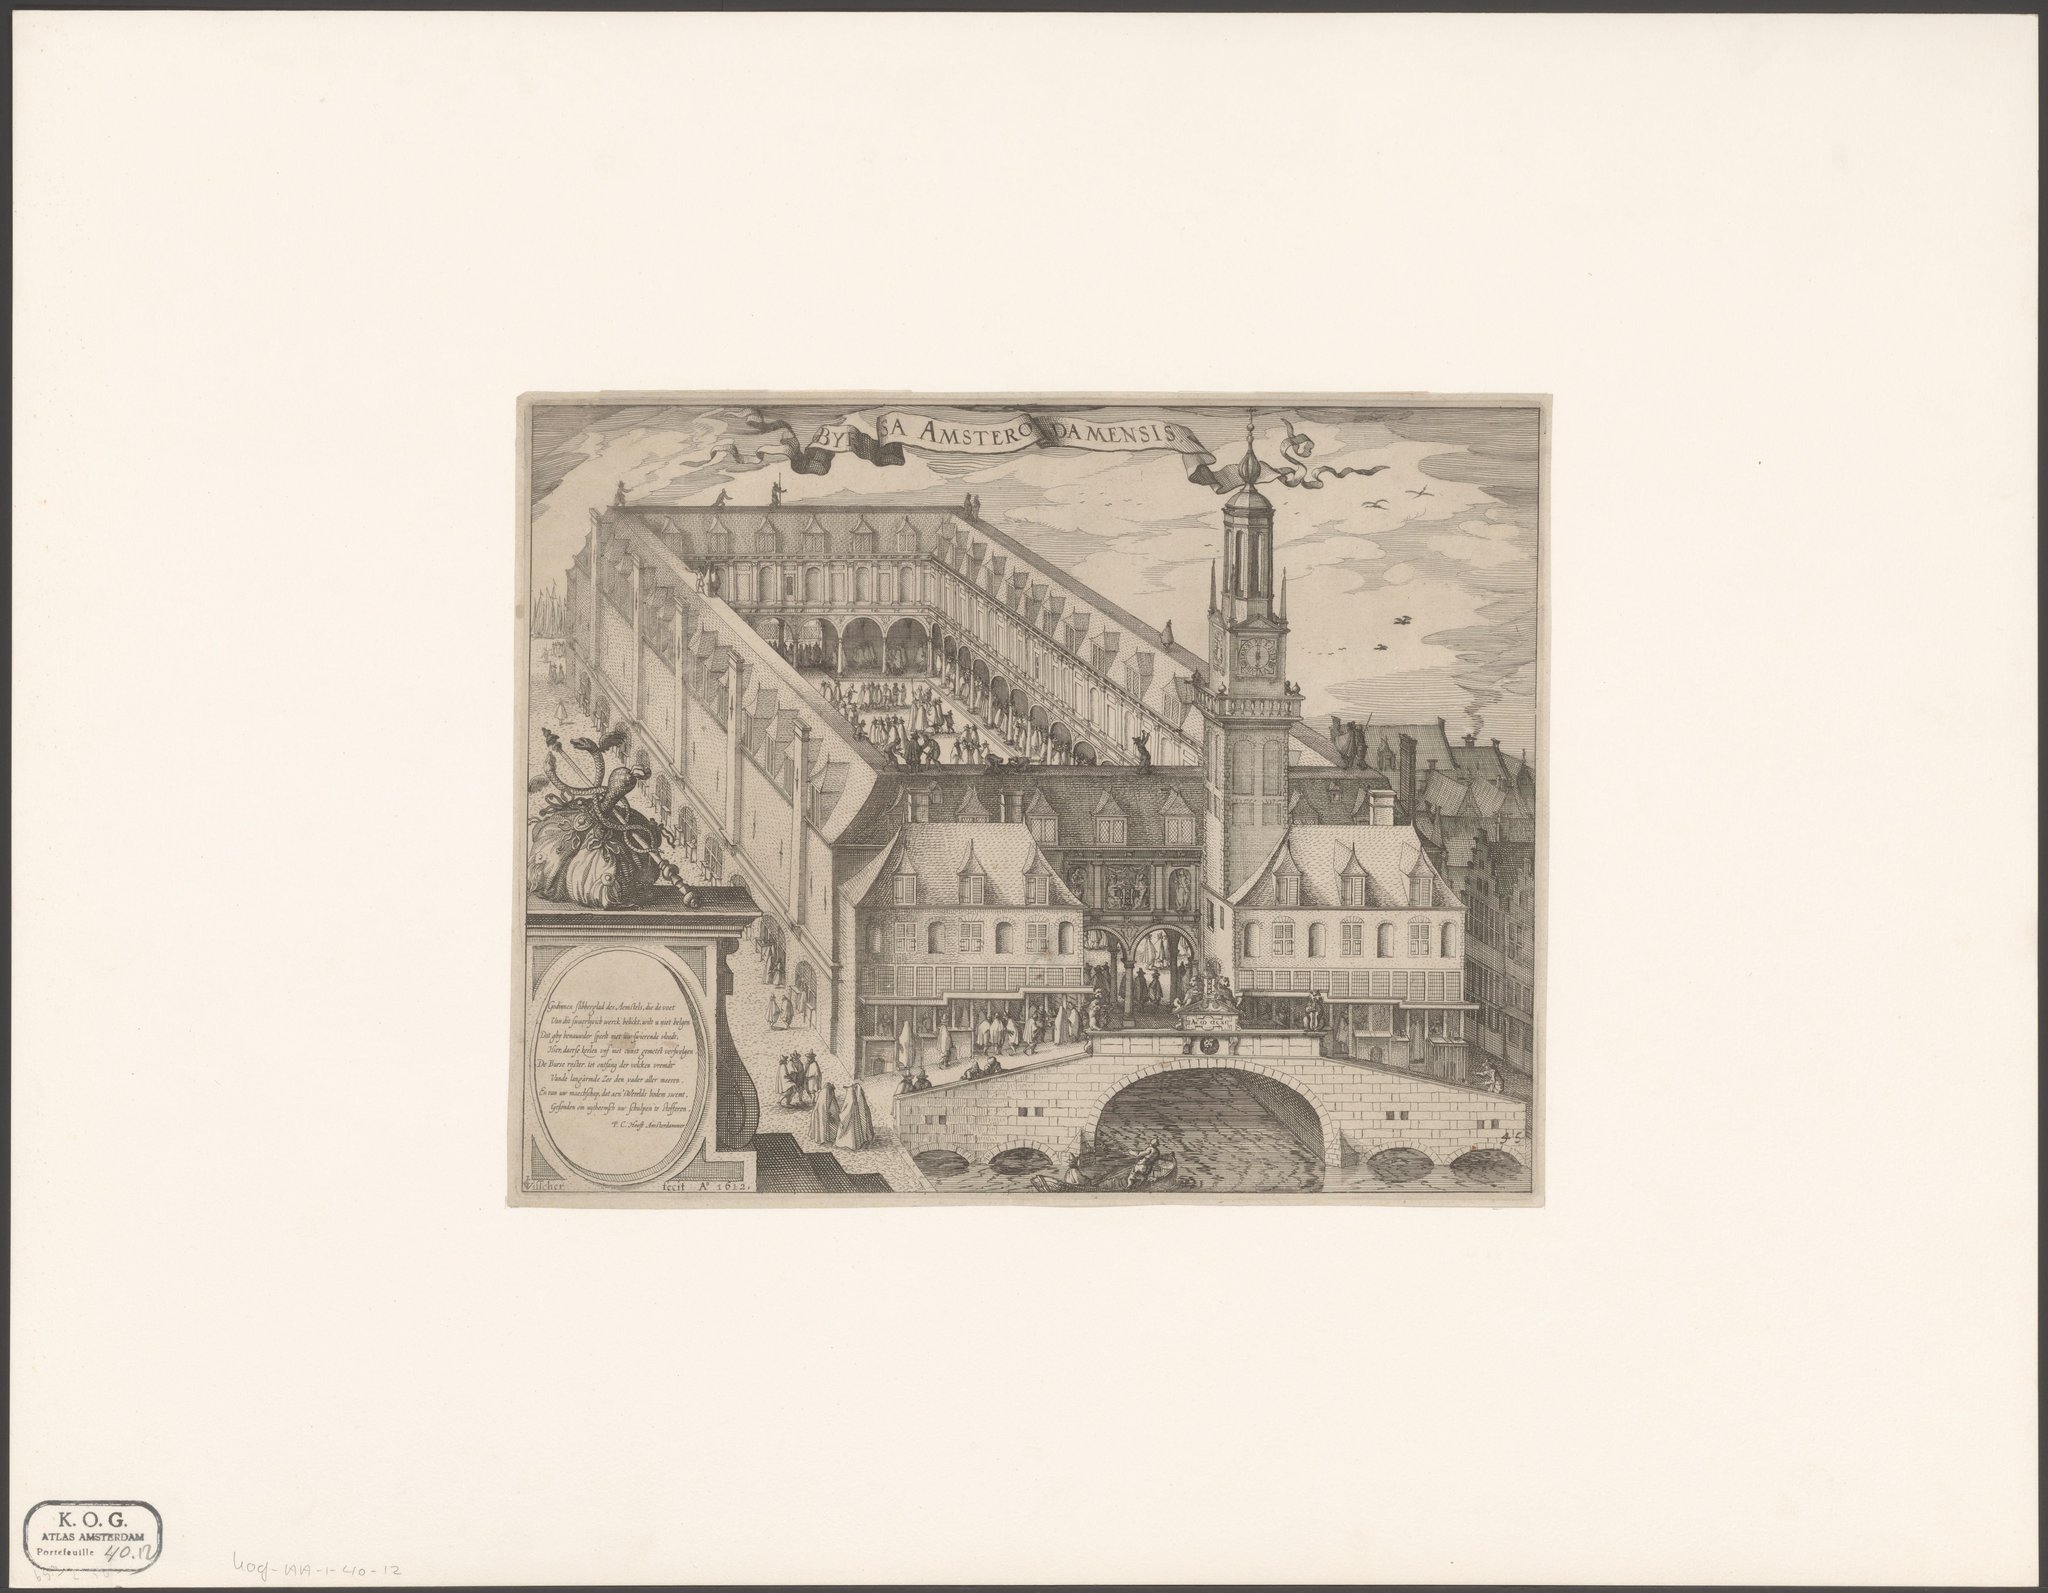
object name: print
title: Byrsa Amsterodamensis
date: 1613-1648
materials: paper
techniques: engraving, etching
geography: amsterdam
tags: bridge in city across river, canal, etc. (+ city(-scape) with figures, staffage), stock exchange, stock-market, courtyard, street (+ city(-scape) with figures, staffage)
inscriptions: collector's mark: Lugt 1641b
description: Prent mogelijk uit: Guicciardini, Lodovico. Beschryvinghe van alle de Neder-landen, anderssins ghenoemt Neder-Duytslandt (…). Amsterdam: Willem Janszoon Blaeu, 1613. Of uit latere edities van 1625, 1646 of 1648, uitgegeven door Willem Janszoon Blaeu of Johannes Janssonius.